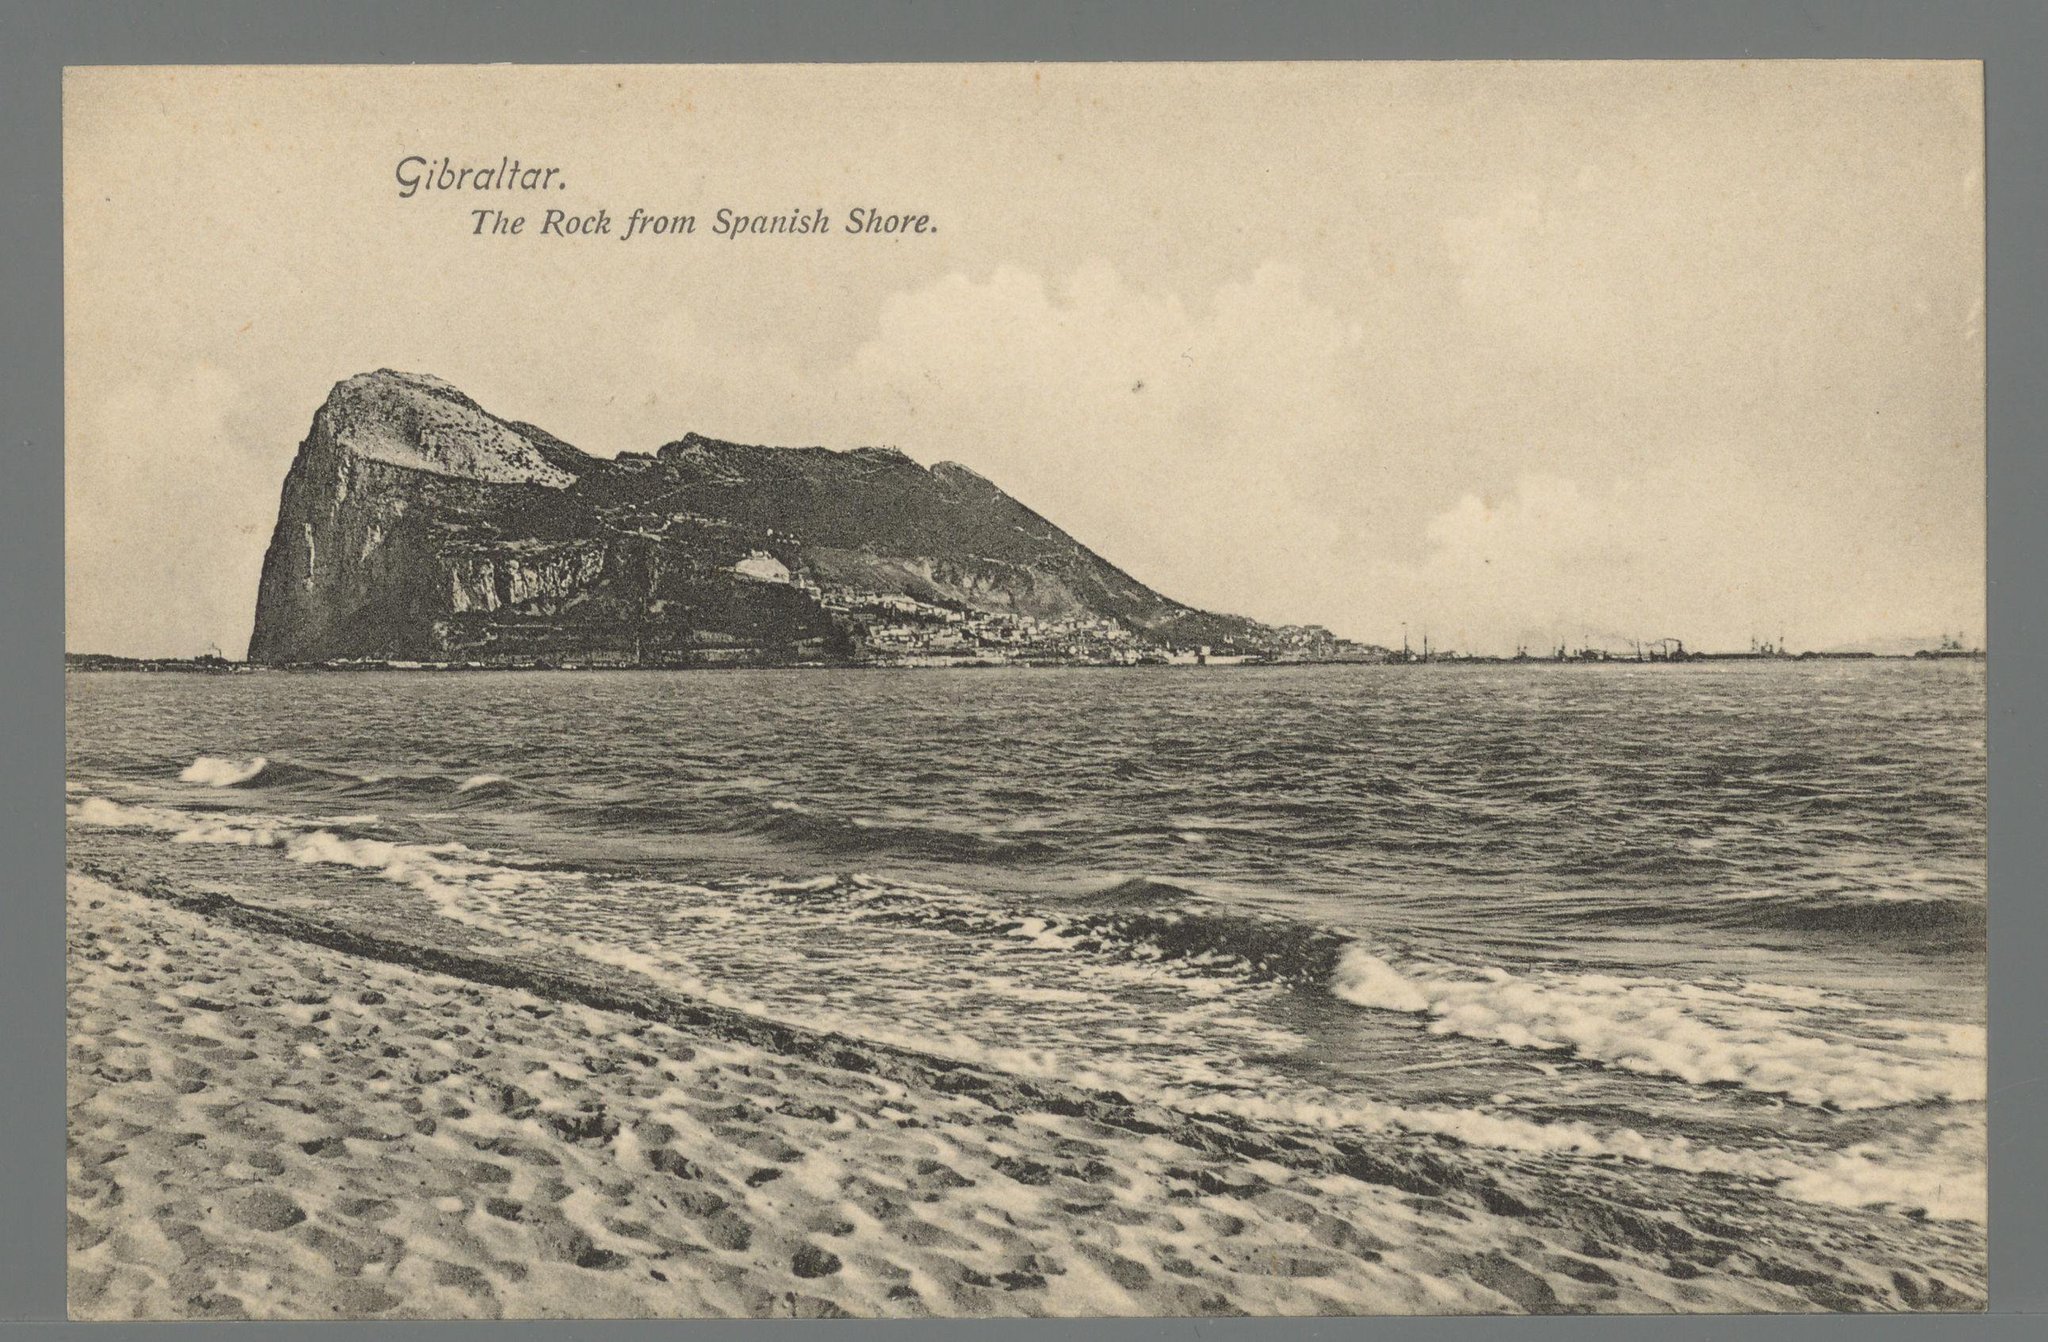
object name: photomechanical print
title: Gibraltar. The Rock from Spanish Shore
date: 1906-1930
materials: cardboard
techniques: photograph, writing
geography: gibraltar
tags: rocks, sea